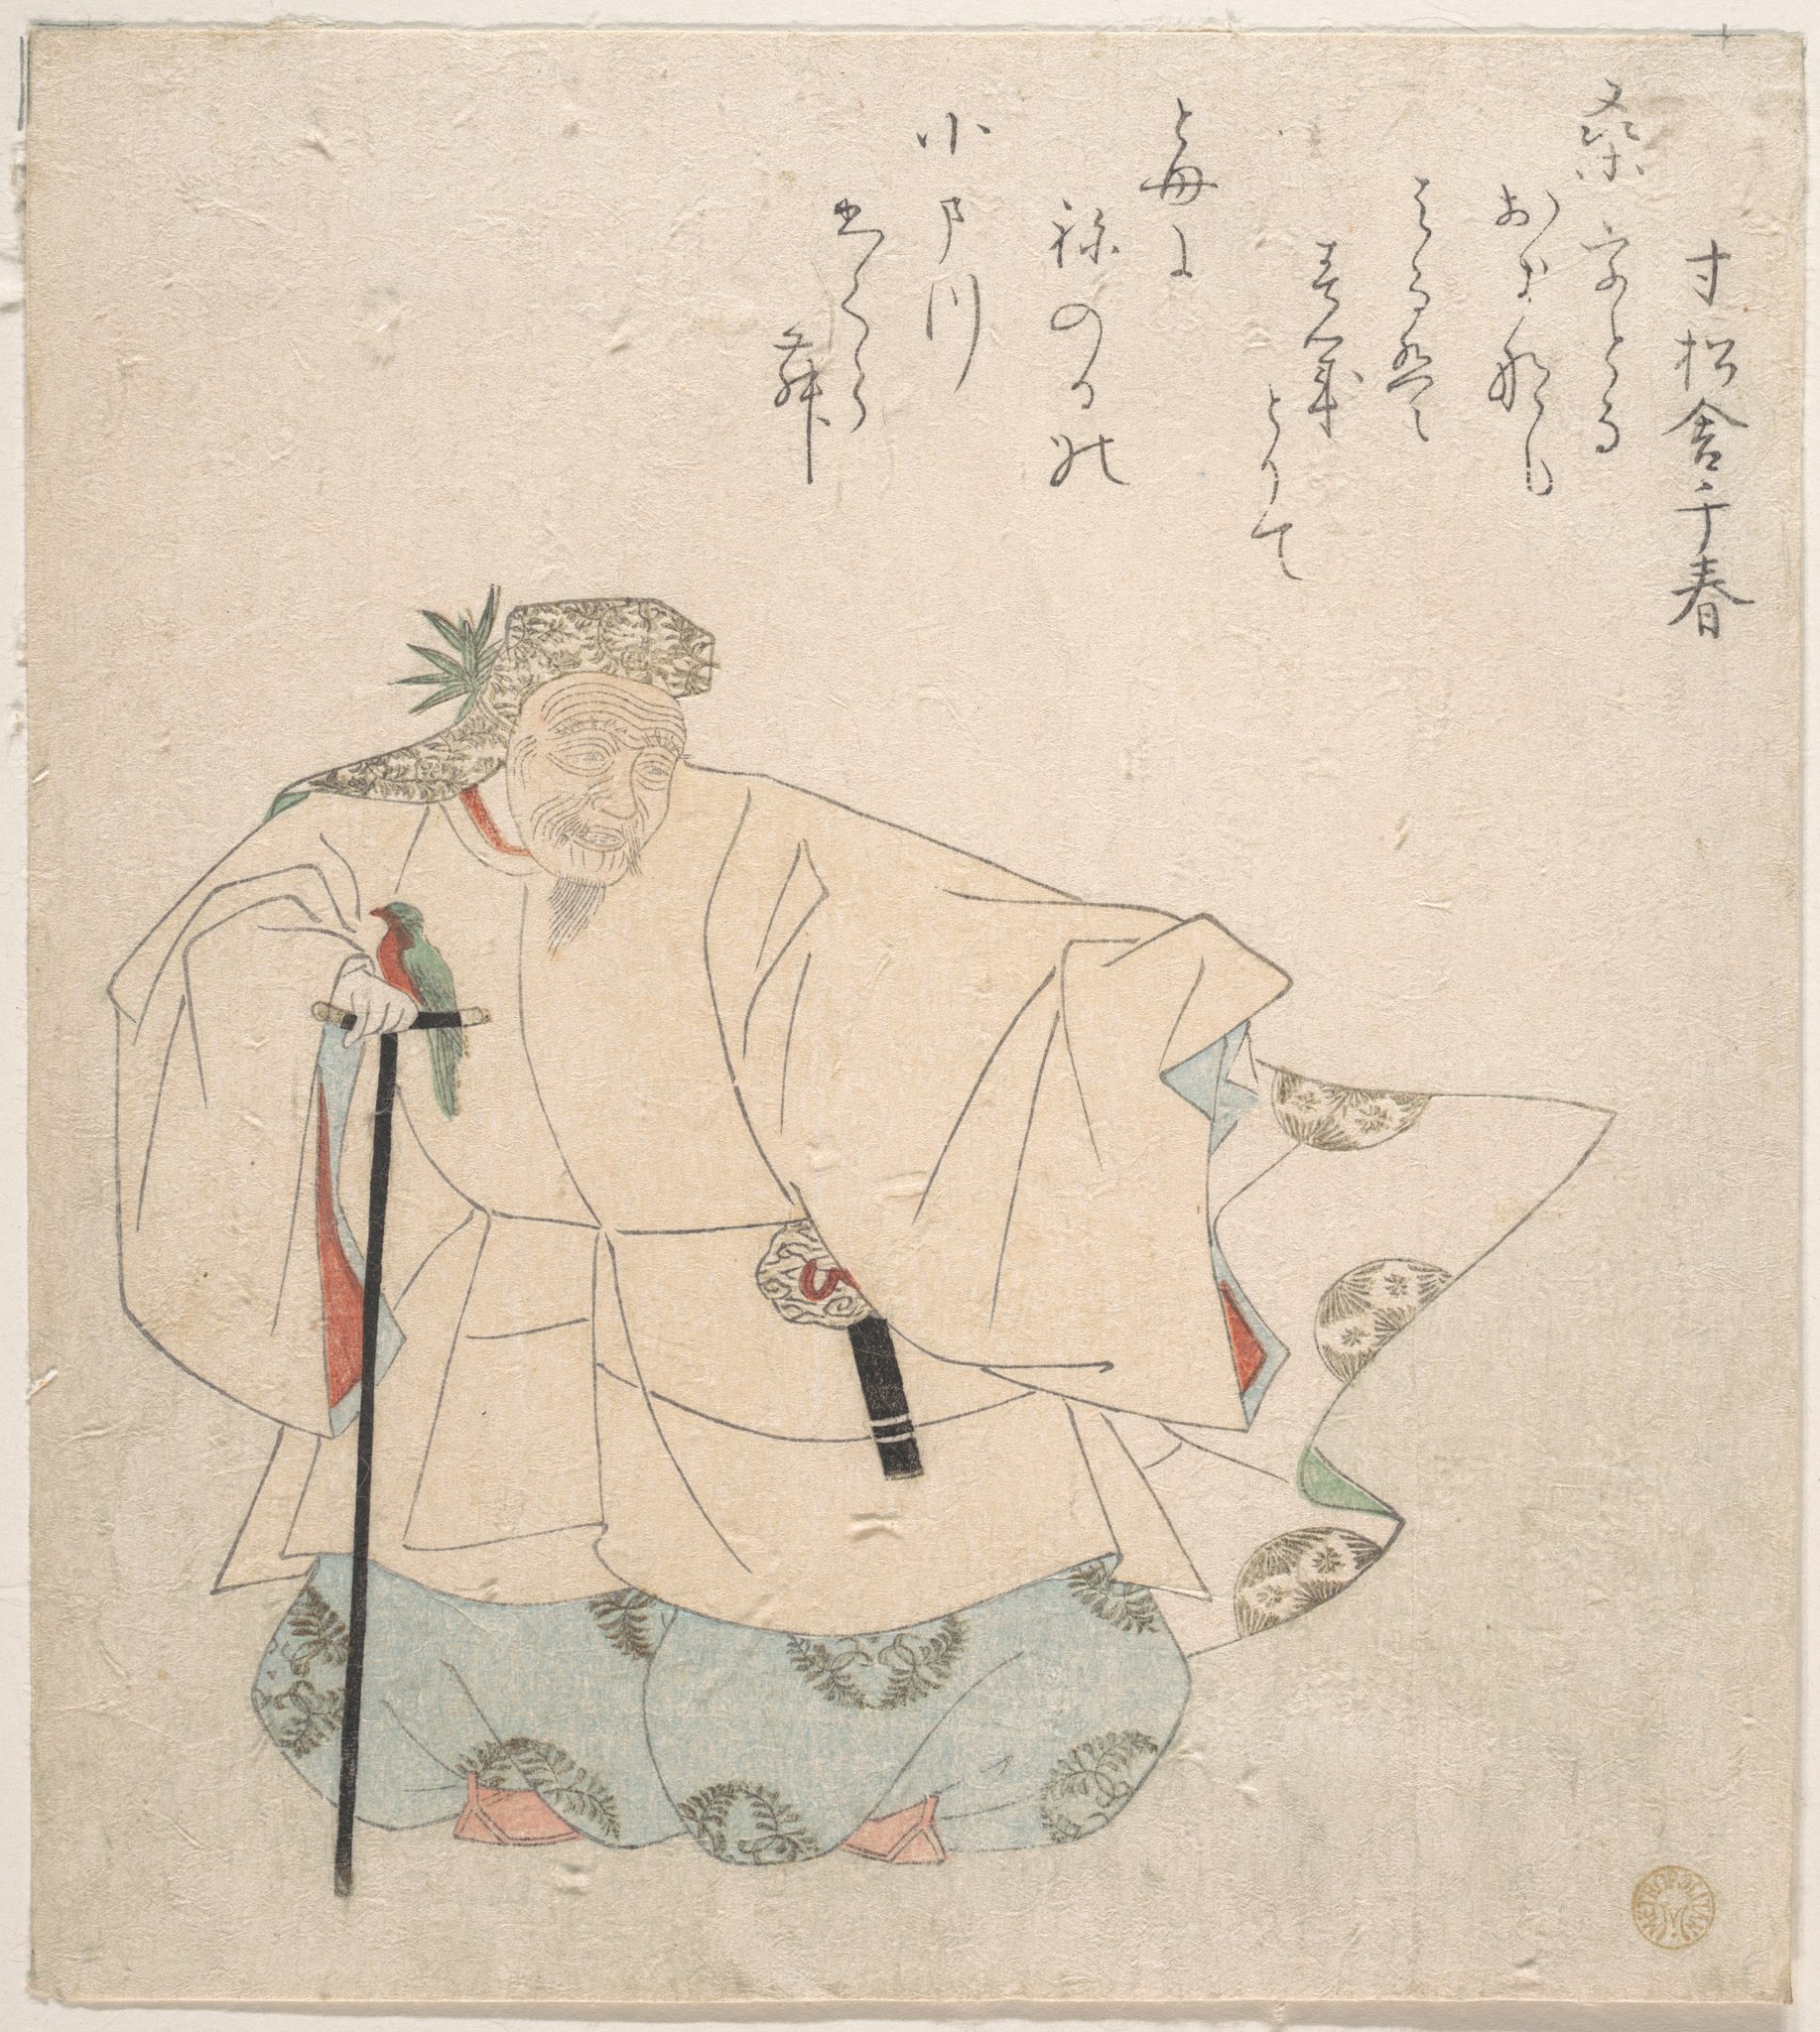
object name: print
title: Scene from Noh Dance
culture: japanese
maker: totoya hokkei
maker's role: artist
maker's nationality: japanese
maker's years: 1780-1850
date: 1820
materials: ink, paper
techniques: surimono, woodblock print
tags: dancing,dancers